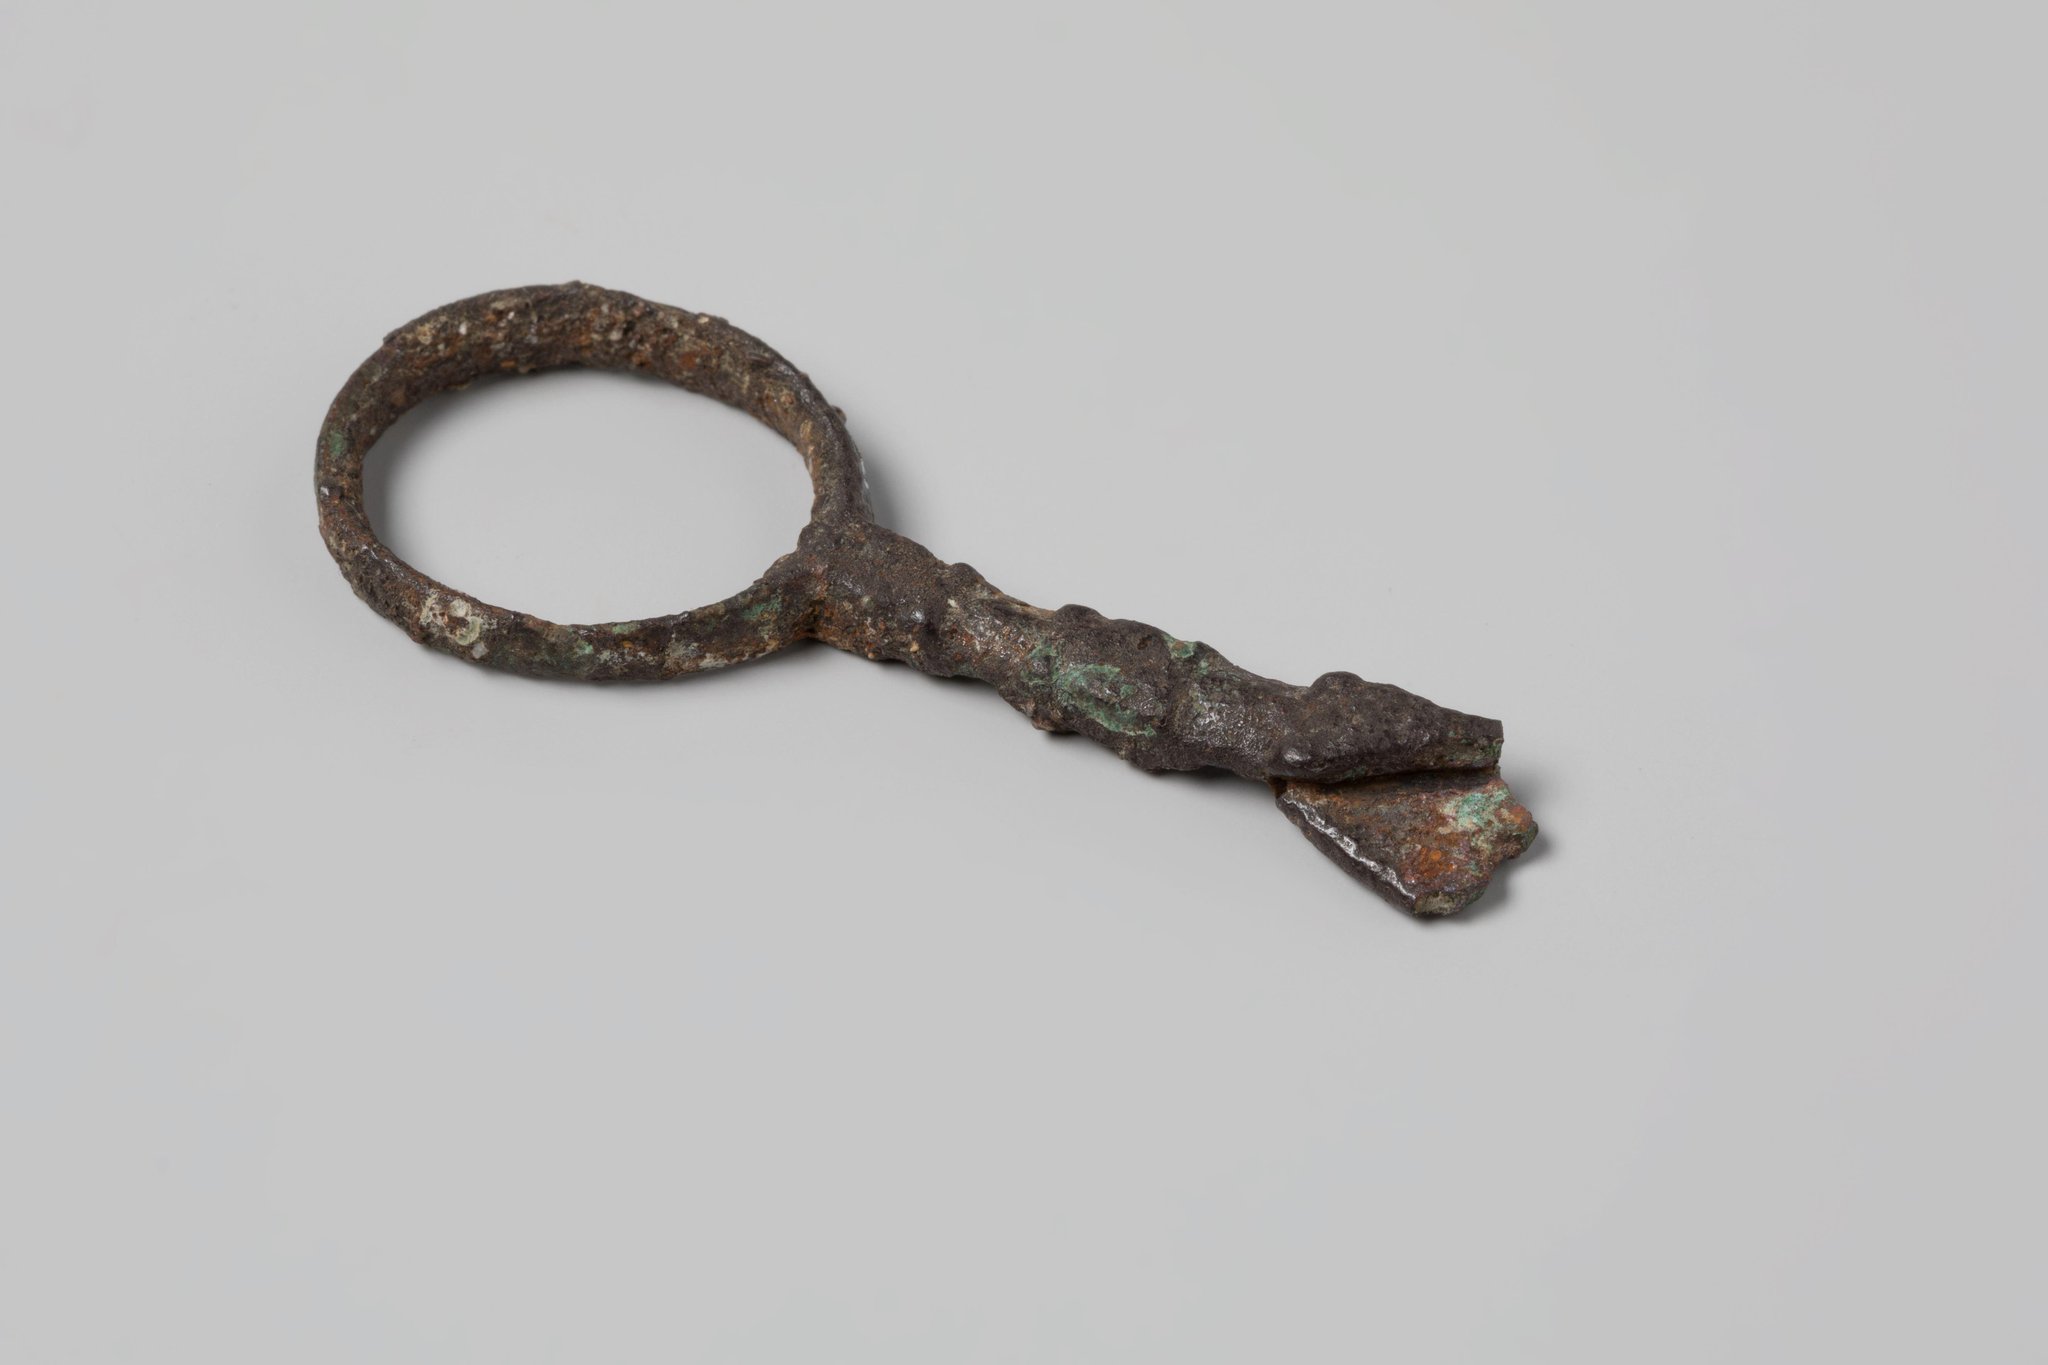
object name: pin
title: Speld uit het wrak van de Oost-Indiëvaarder Hollandia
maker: Anonymous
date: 1700-1743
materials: copper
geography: netherlands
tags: verenigde oostindische compagnie, hollandia (schip), annet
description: Tools and instruments, sewing and sailmaking, pin; fragm of shaft with bow, id. NG 1980-27H3265.